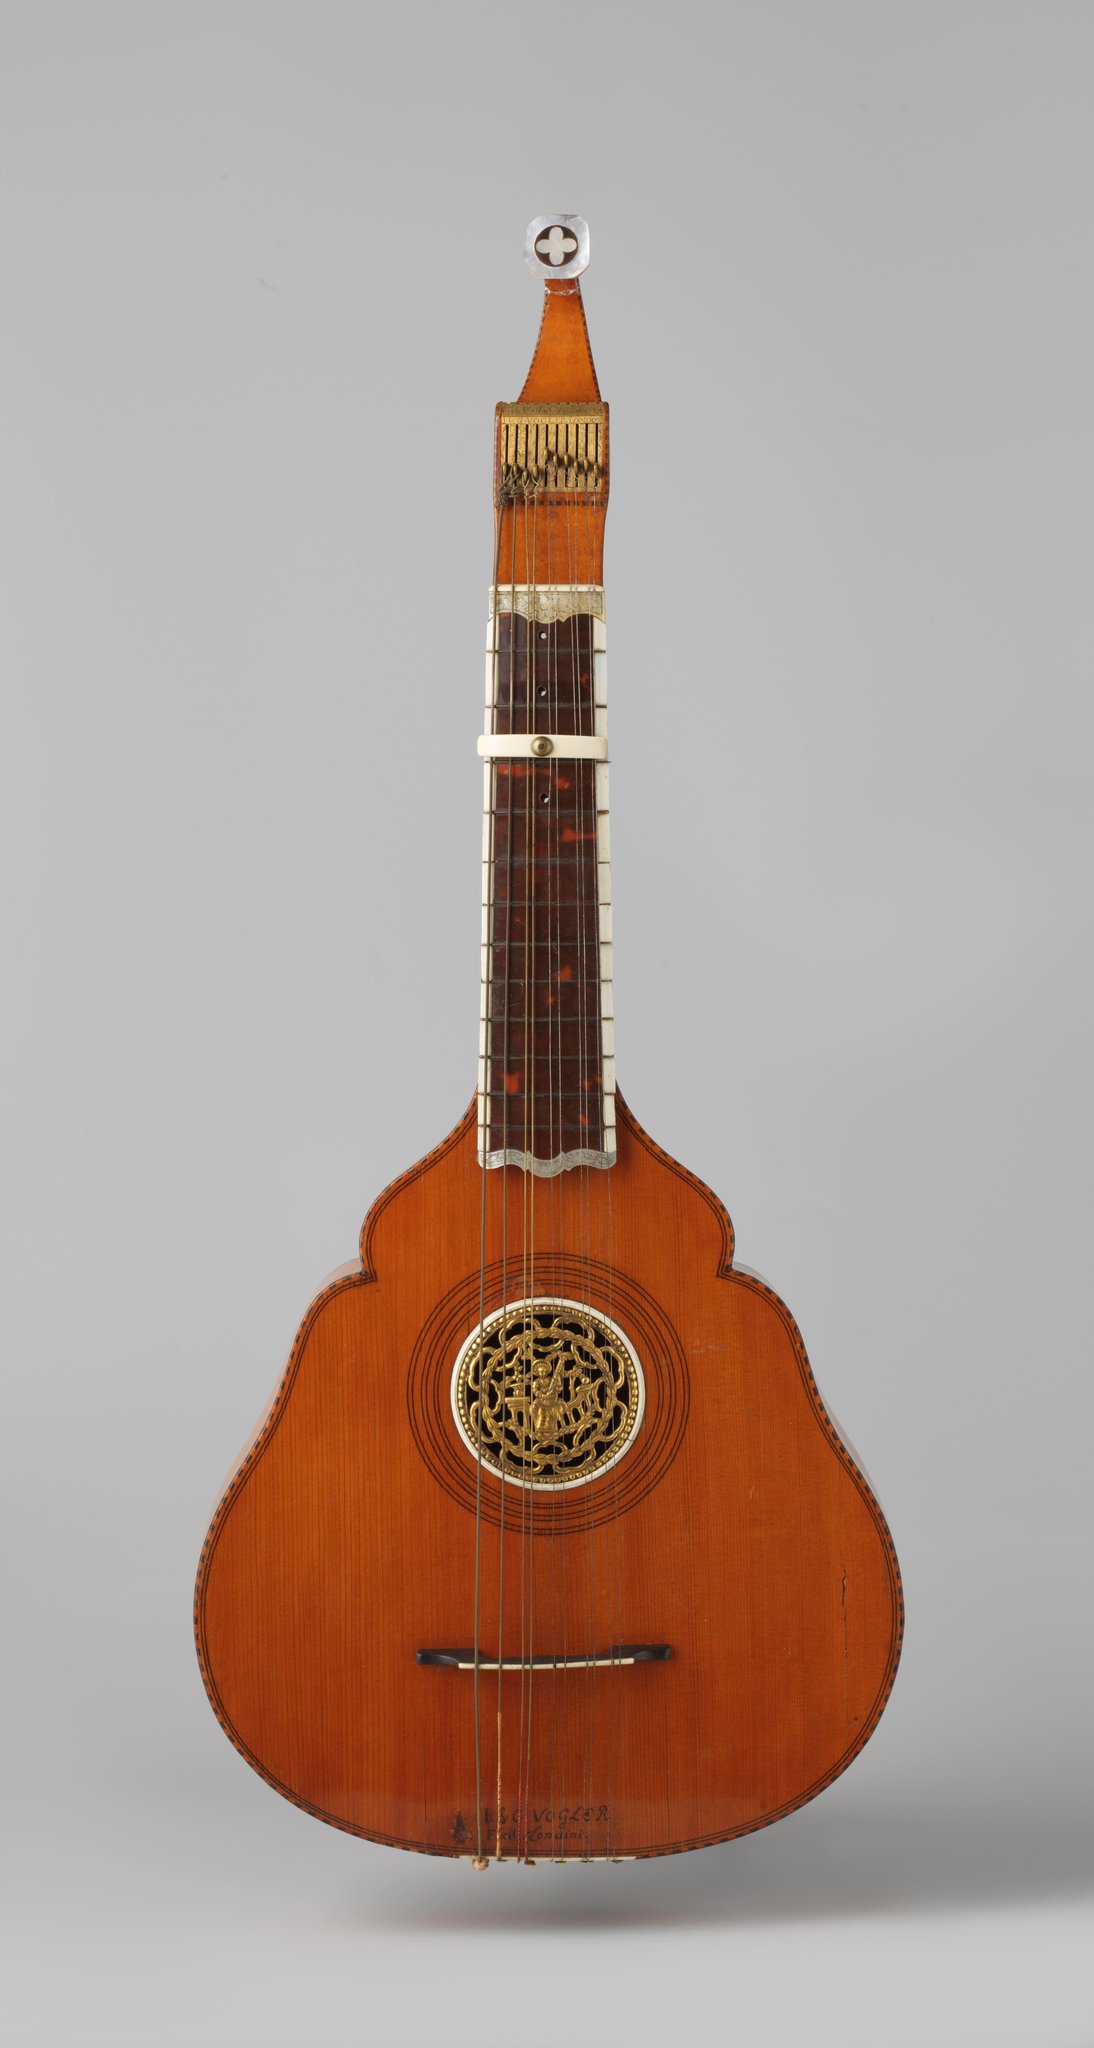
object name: musical instrument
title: English Guitar, John and Gerard Vogler (active 1777-1785), London, c. 1780, spruce, maple, ebony, metal, ivory, mother-of-pearl, tortoise shell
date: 1780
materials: copper, mother of pearl, shell, wood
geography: london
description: Engelse gitaar van geelbruin hout met zwarte randen; toets van schildpad met parelmoer. Het galmgat is afgedekt met een opengewerkte versiering van koper met een gitaarspelende vrouw. Gemerkt: I.?. g. VOGLER, LONDON.